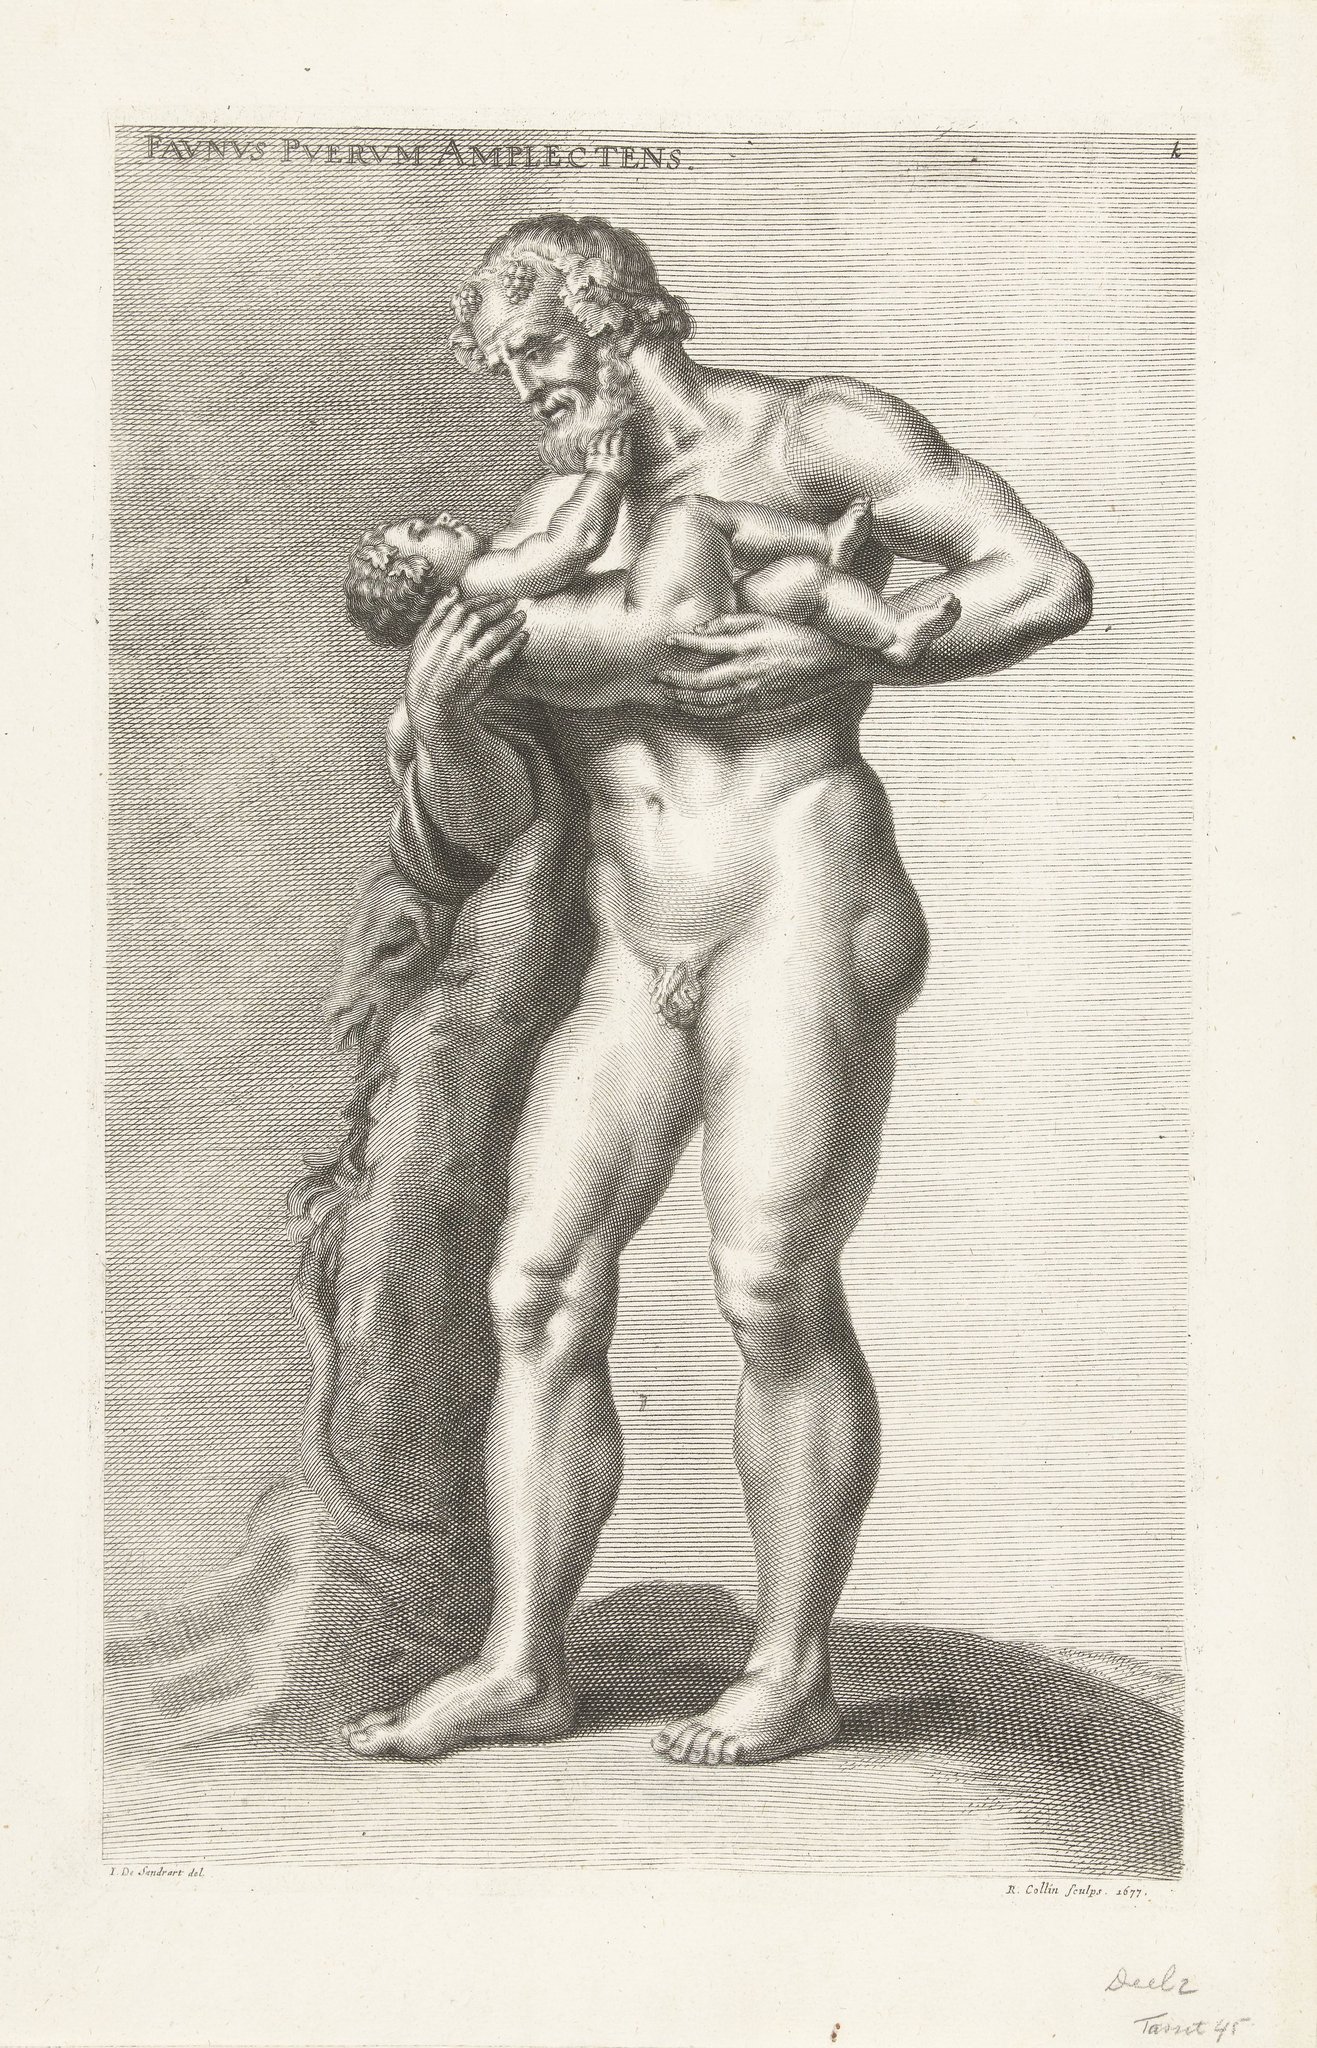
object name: book illustration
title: Faun met kind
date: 1677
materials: paper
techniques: engraving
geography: antwerp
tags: satyrs, fauns, sileni, piece of sculpture, reproduction of a piece of sculpture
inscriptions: collector's mark: Lugt 2228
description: Illustratie voor: Joachim von Sandrart, L'Academia Todesca della Architectura Scultura e Pittura oder Teutsche Academie der Edlen Bau-, Bild- und Mahlerey-Künste. Nürnberg: 1675-1680. Deel 2.